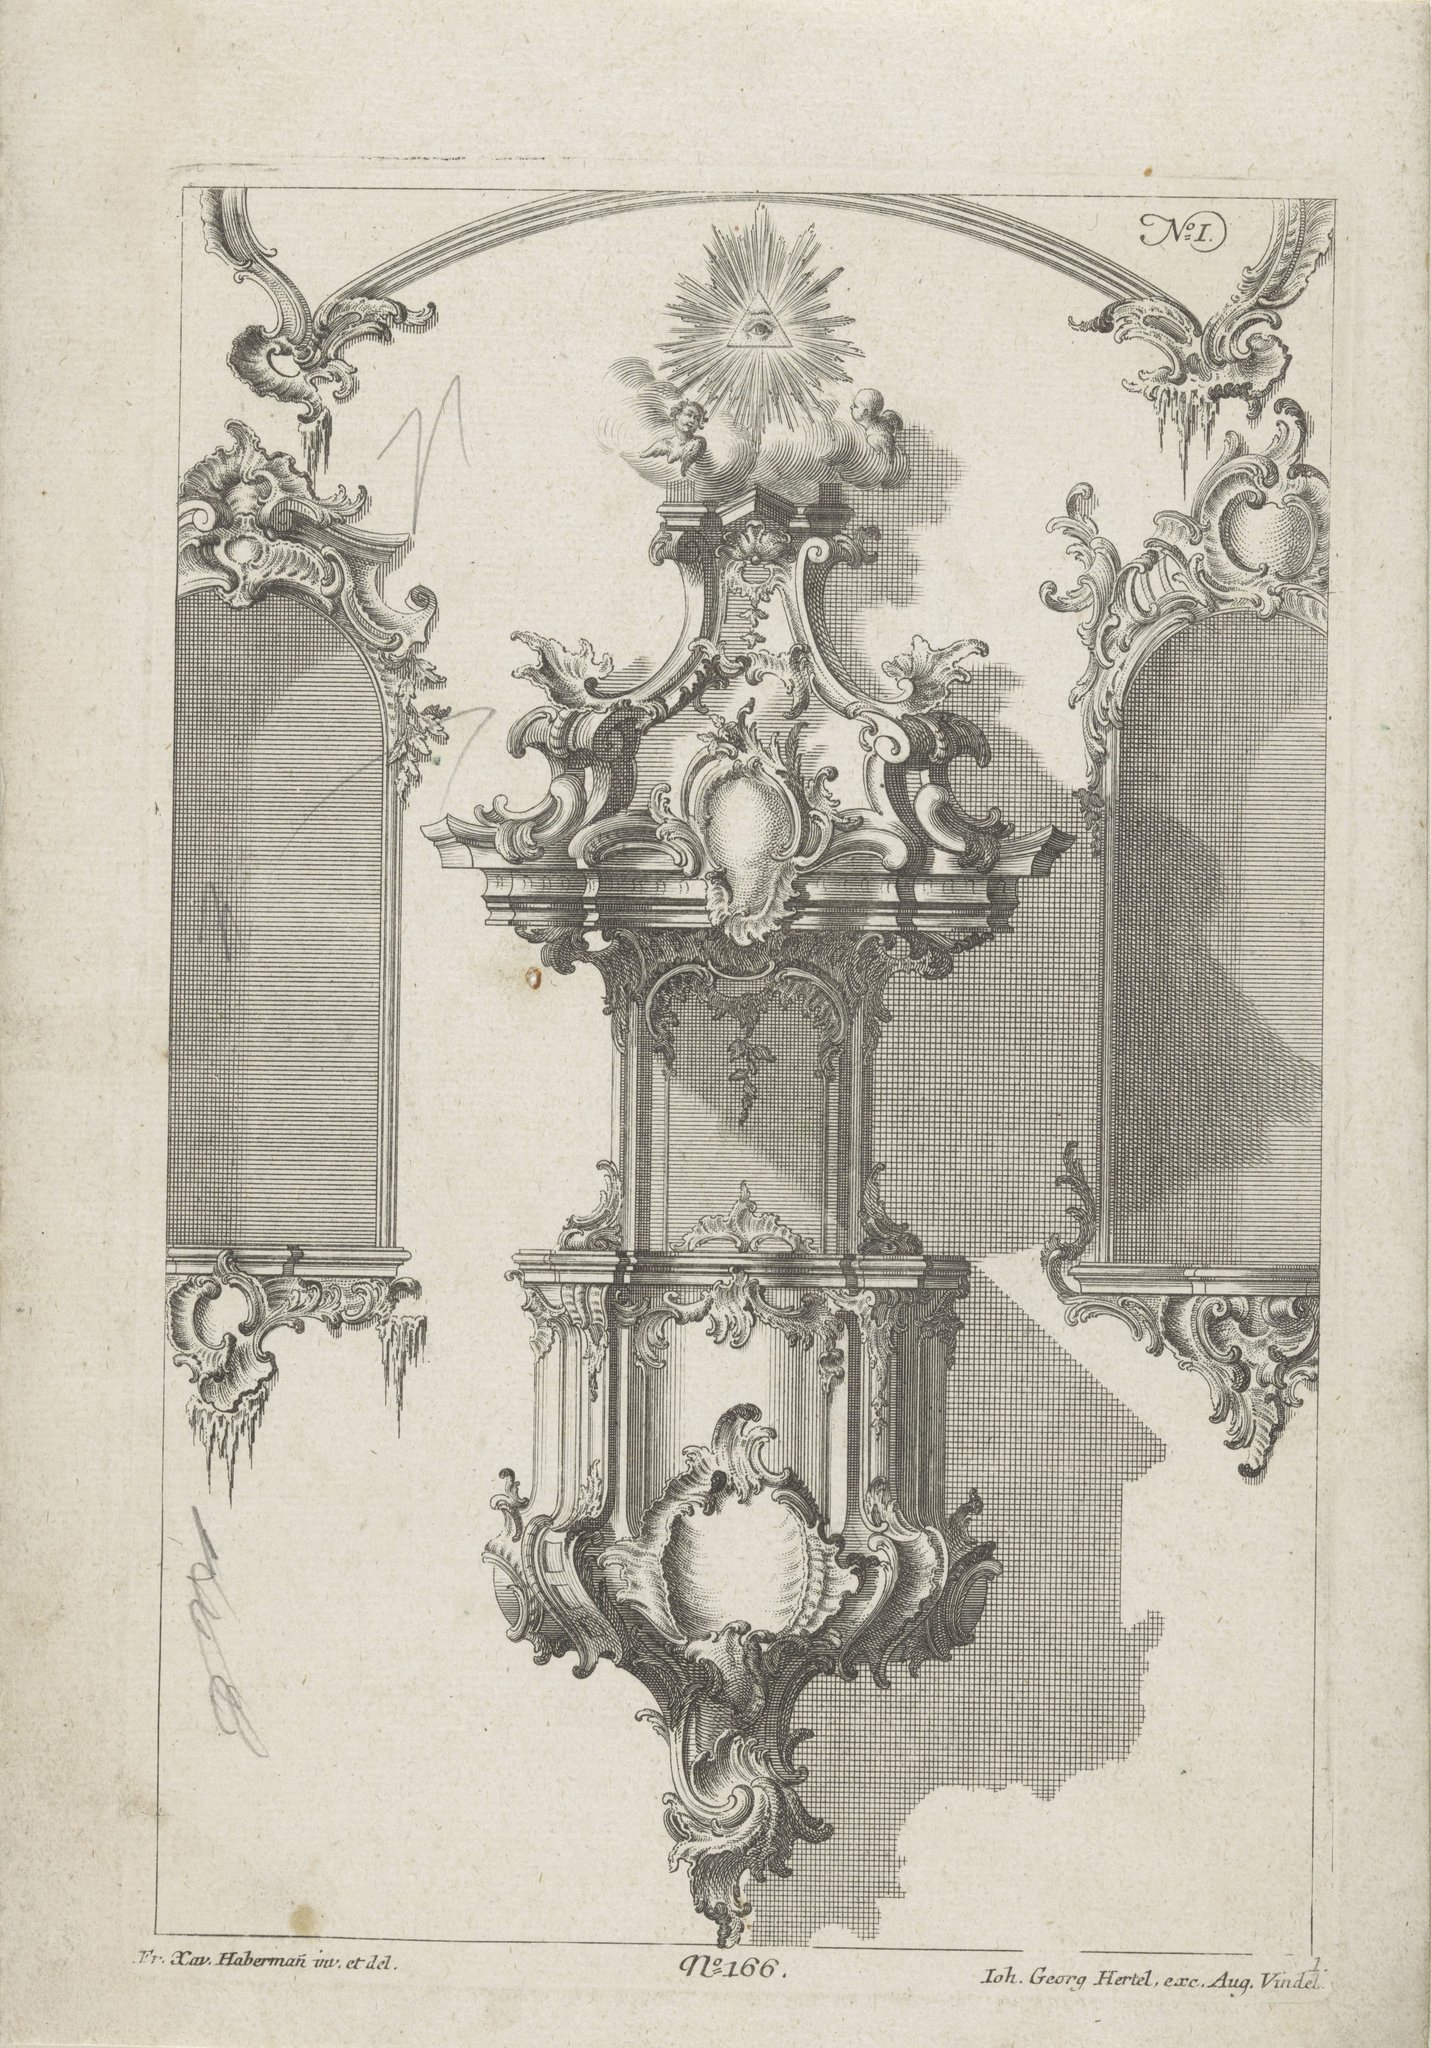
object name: print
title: Preekstoel met alziend oog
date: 1740-1745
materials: paper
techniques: engraving, etching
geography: augsburg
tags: rocaille ornament, pulpit, ambo, chancel, the all-seeing eye, triangle with eye ~ symbol of god the father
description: Preekstoel met rocaille ornamenten tussen twee panelen. Aan bovenzijde gevleugelde putti en het alziend oog met stralenkrans. Uitgeversnummer 166.